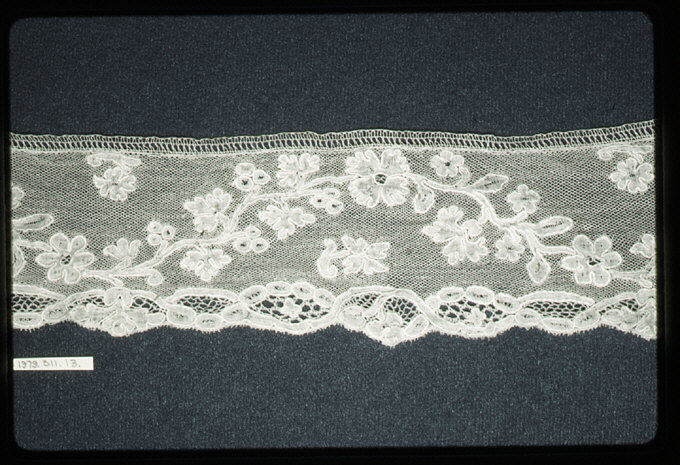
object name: edging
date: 1701-1800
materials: linen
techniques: lace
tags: flowers